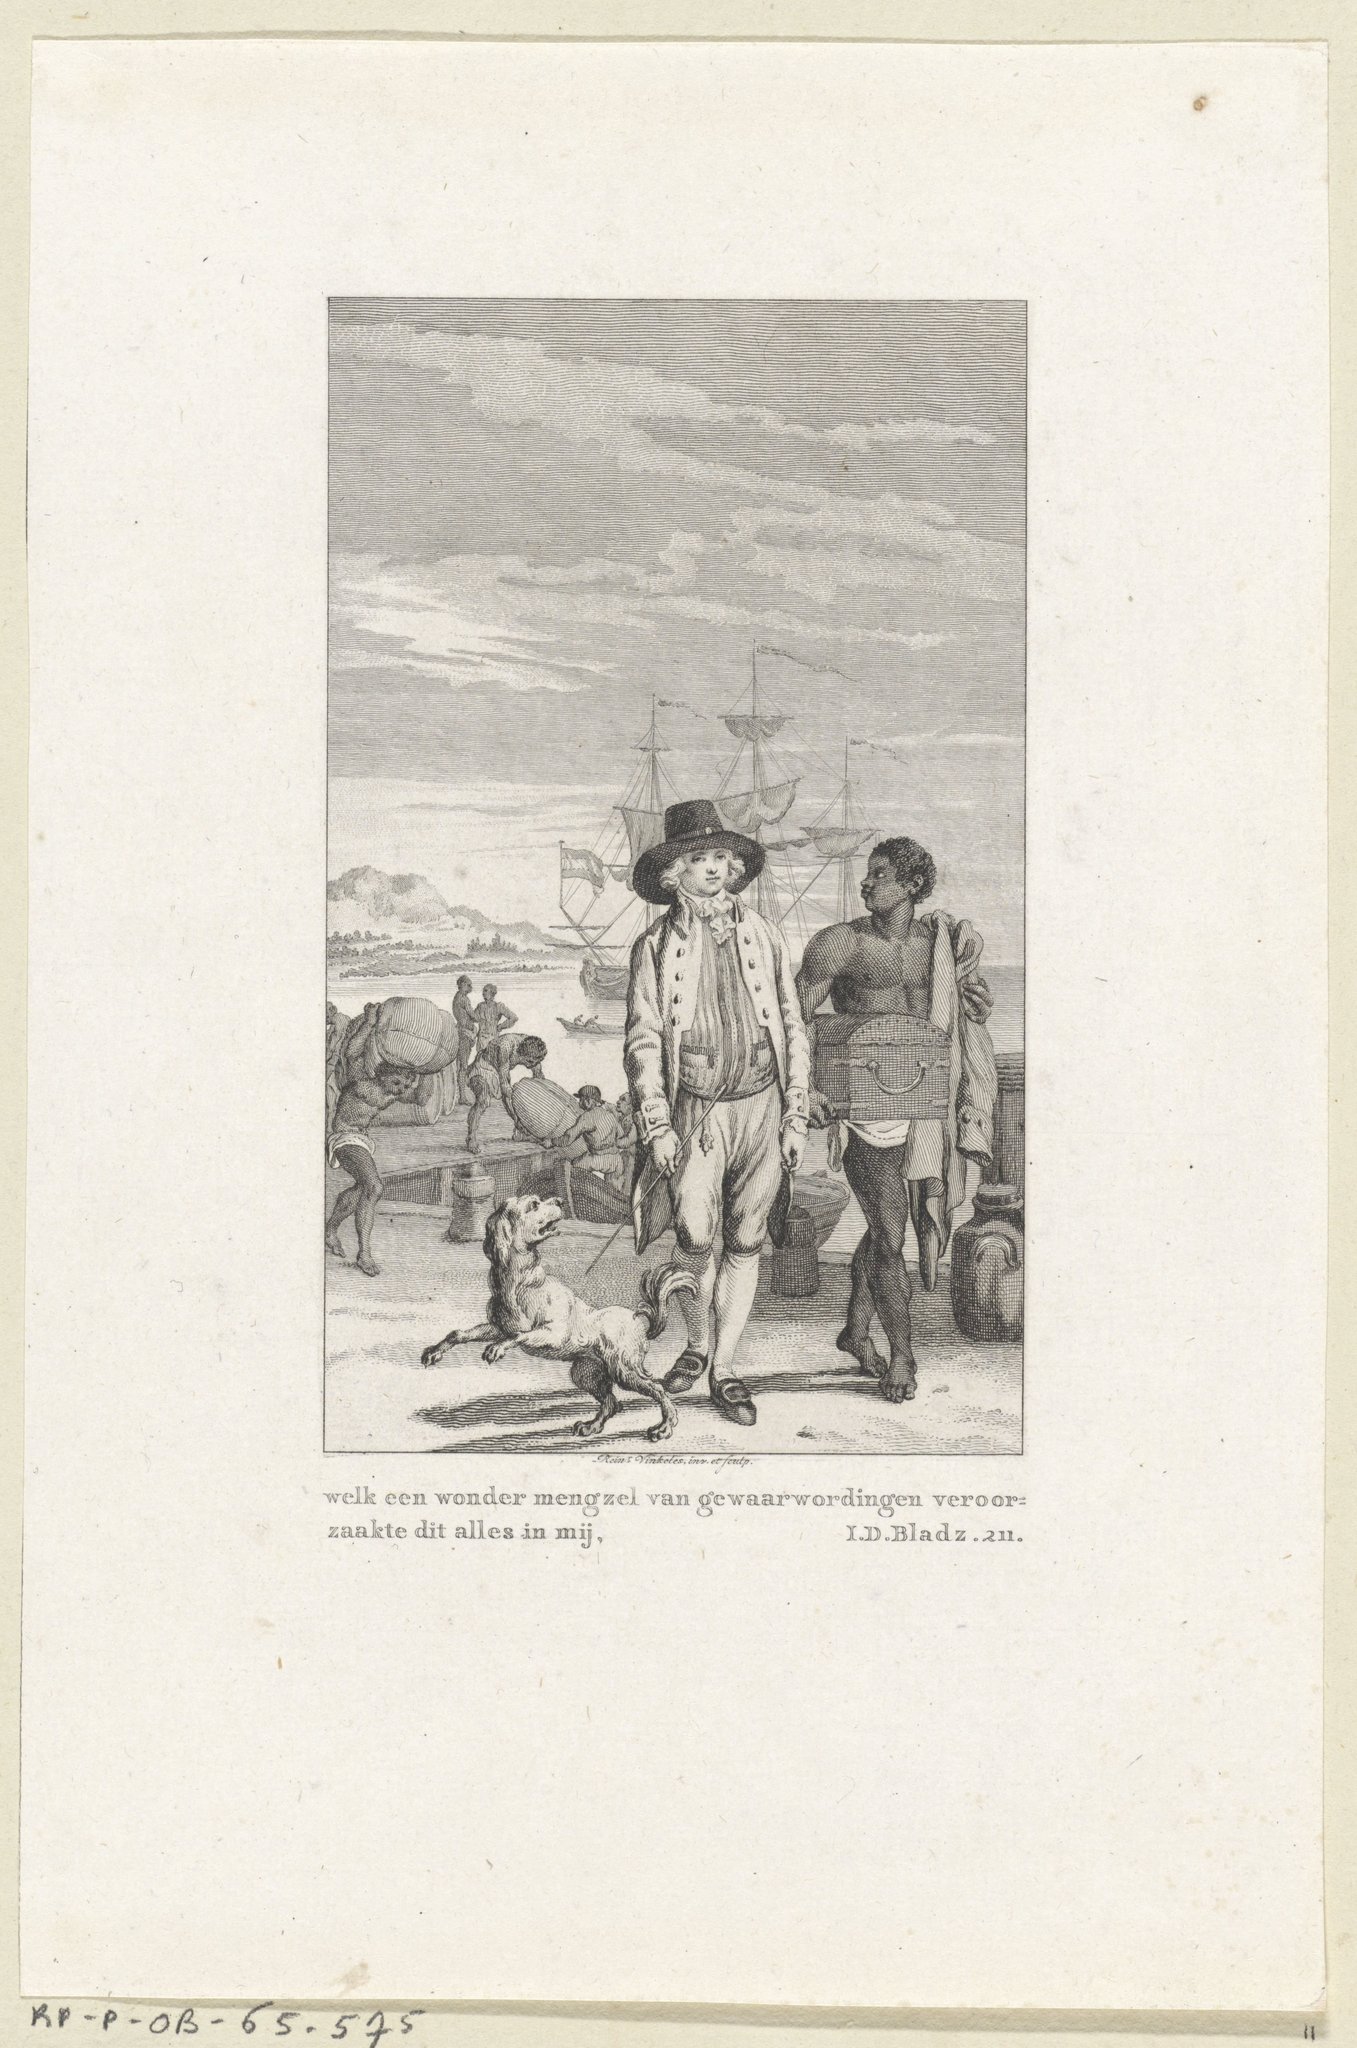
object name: print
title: Tot slaaf gemaakte man draagt Reinharts bagage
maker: reinier vinkeles (i)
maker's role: draughtsman, print maker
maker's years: 1741-1816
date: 1791-1798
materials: paper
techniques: engraving, etching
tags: luggage, travel requisites, slavery; serfs and enslaved persons, human races, peoples and nationalities (other than prehistoric or extinct), quay, dog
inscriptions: collector's mark: Lugt 240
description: Prent gebruikt in: Post, Elisabeth Maria. Reinhart, of Natuur en Godsdienst. 3 dln. 1e druk. Amsterdam: Johannes Allart, 1791-1792, dl. 1 (1791), p. 211. En in: Post, Elisabeth Maria. Reinhart, of Natuur en Godsdienst. 3 dln. 2e druk. Amsterdam: Johannes Allart, 1798-1802, dl. 1 (1798), p. 211.